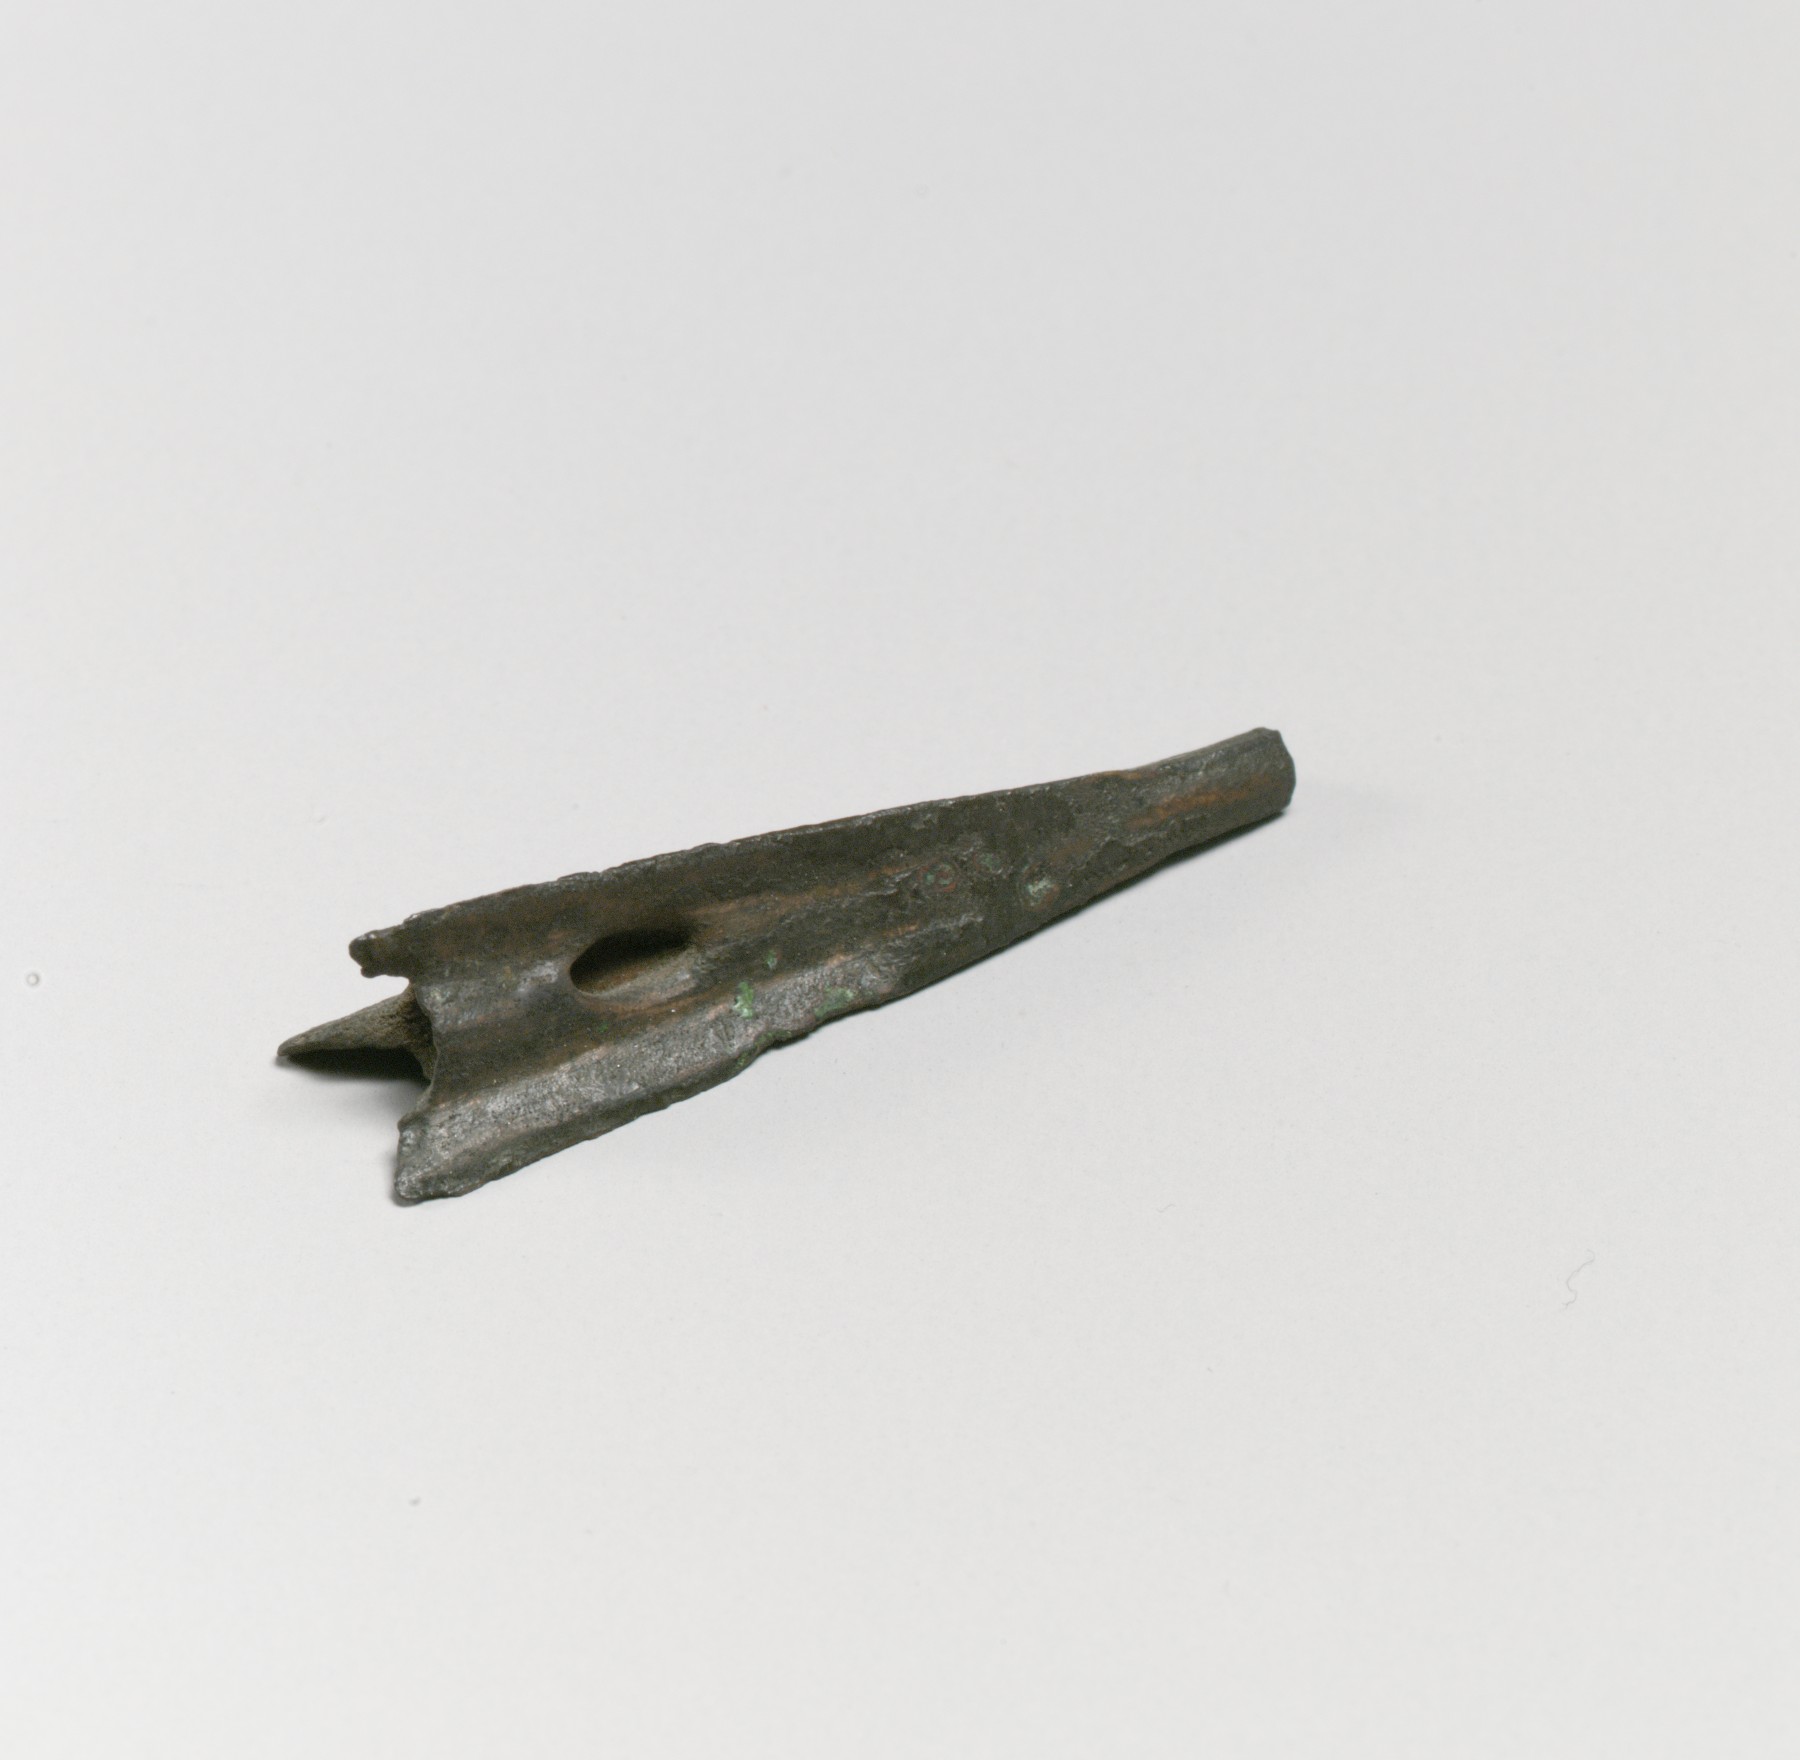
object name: arrowhead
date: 7000 BCE-330 CE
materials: bronze